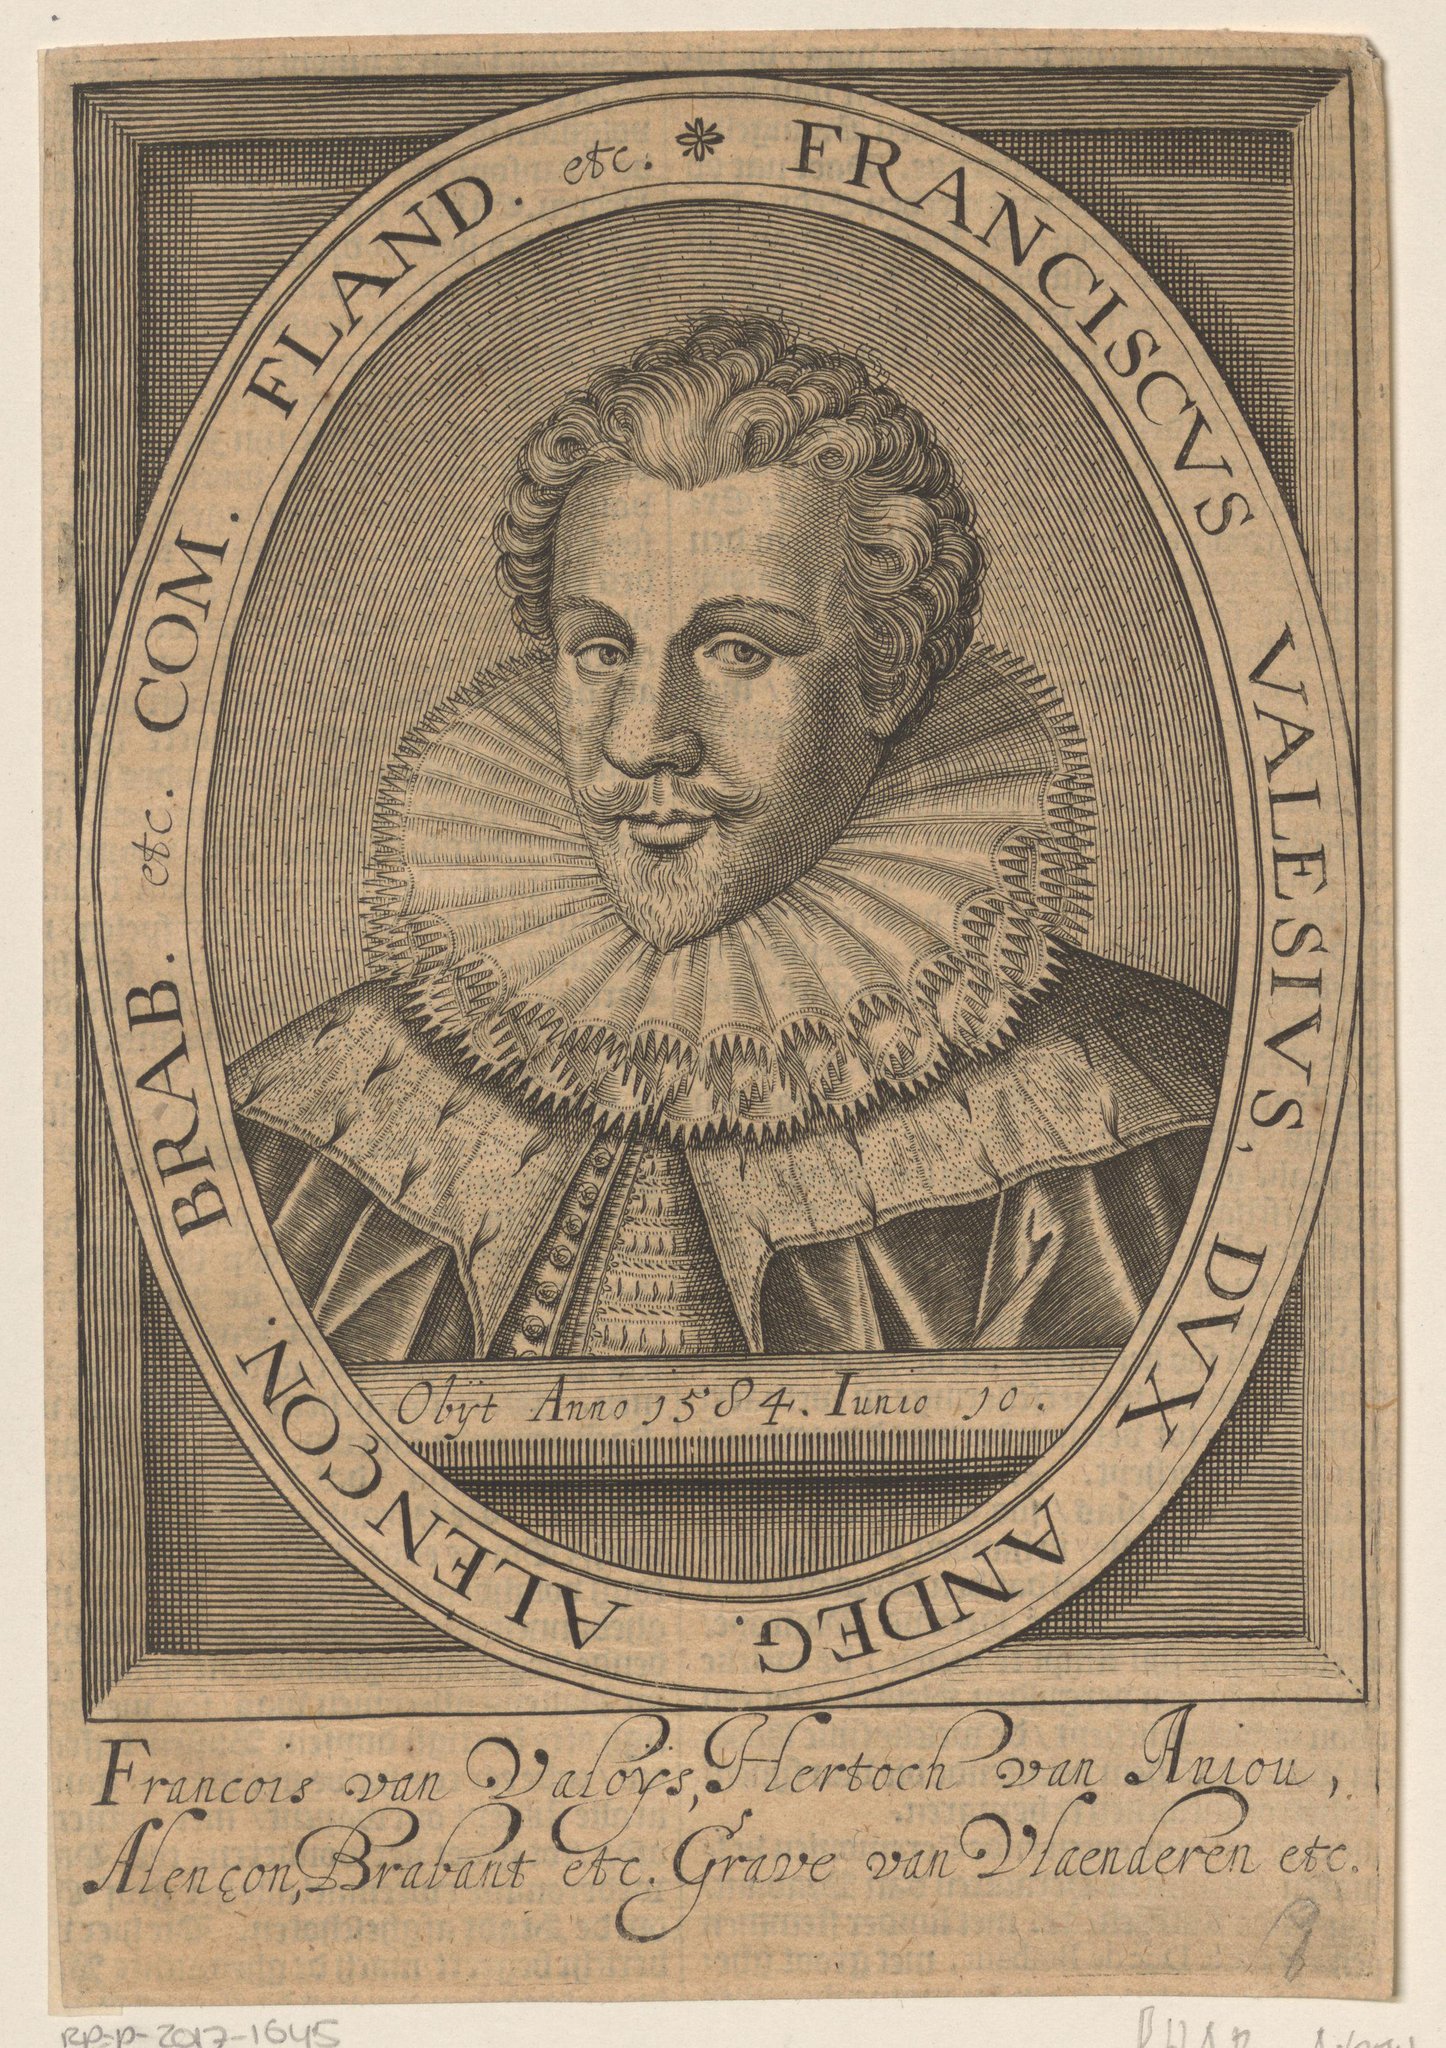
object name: book illustration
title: Portret van François-Hercule de Valois, hertog van Anjou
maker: Anonymous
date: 1600-1699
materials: paper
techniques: engraving, letterpress printing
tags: paris, françois-hercule de valois (hertog van anjou)